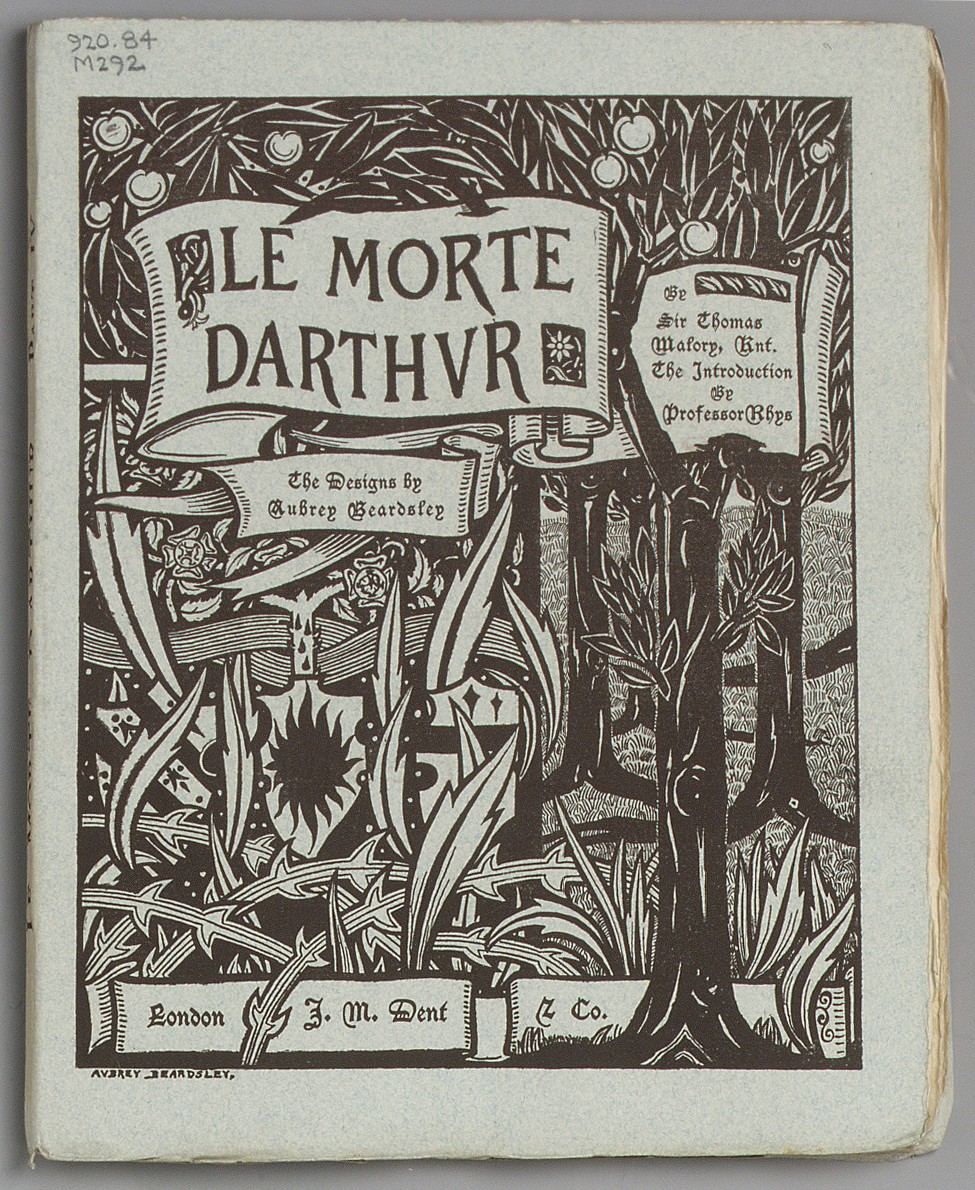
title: Morte d'Arthur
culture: british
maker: sir thomas malory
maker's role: author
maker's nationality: british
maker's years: 1415-1471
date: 1893